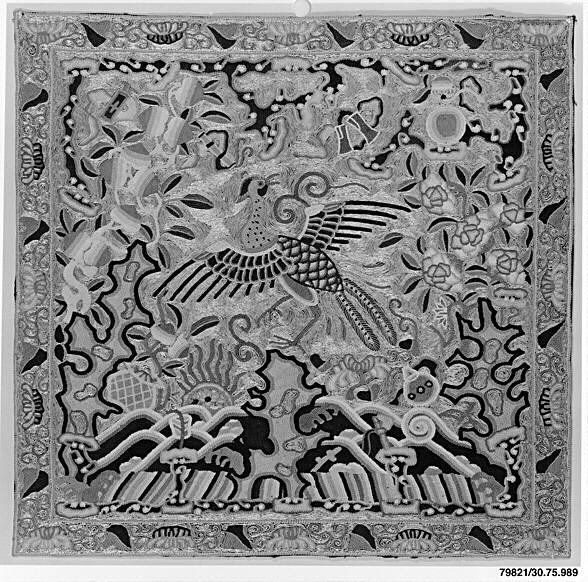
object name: rank badge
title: Rank Badge with Golden Pheasant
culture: chinese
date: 1701-1733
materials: metal thread, silk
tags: pheasants